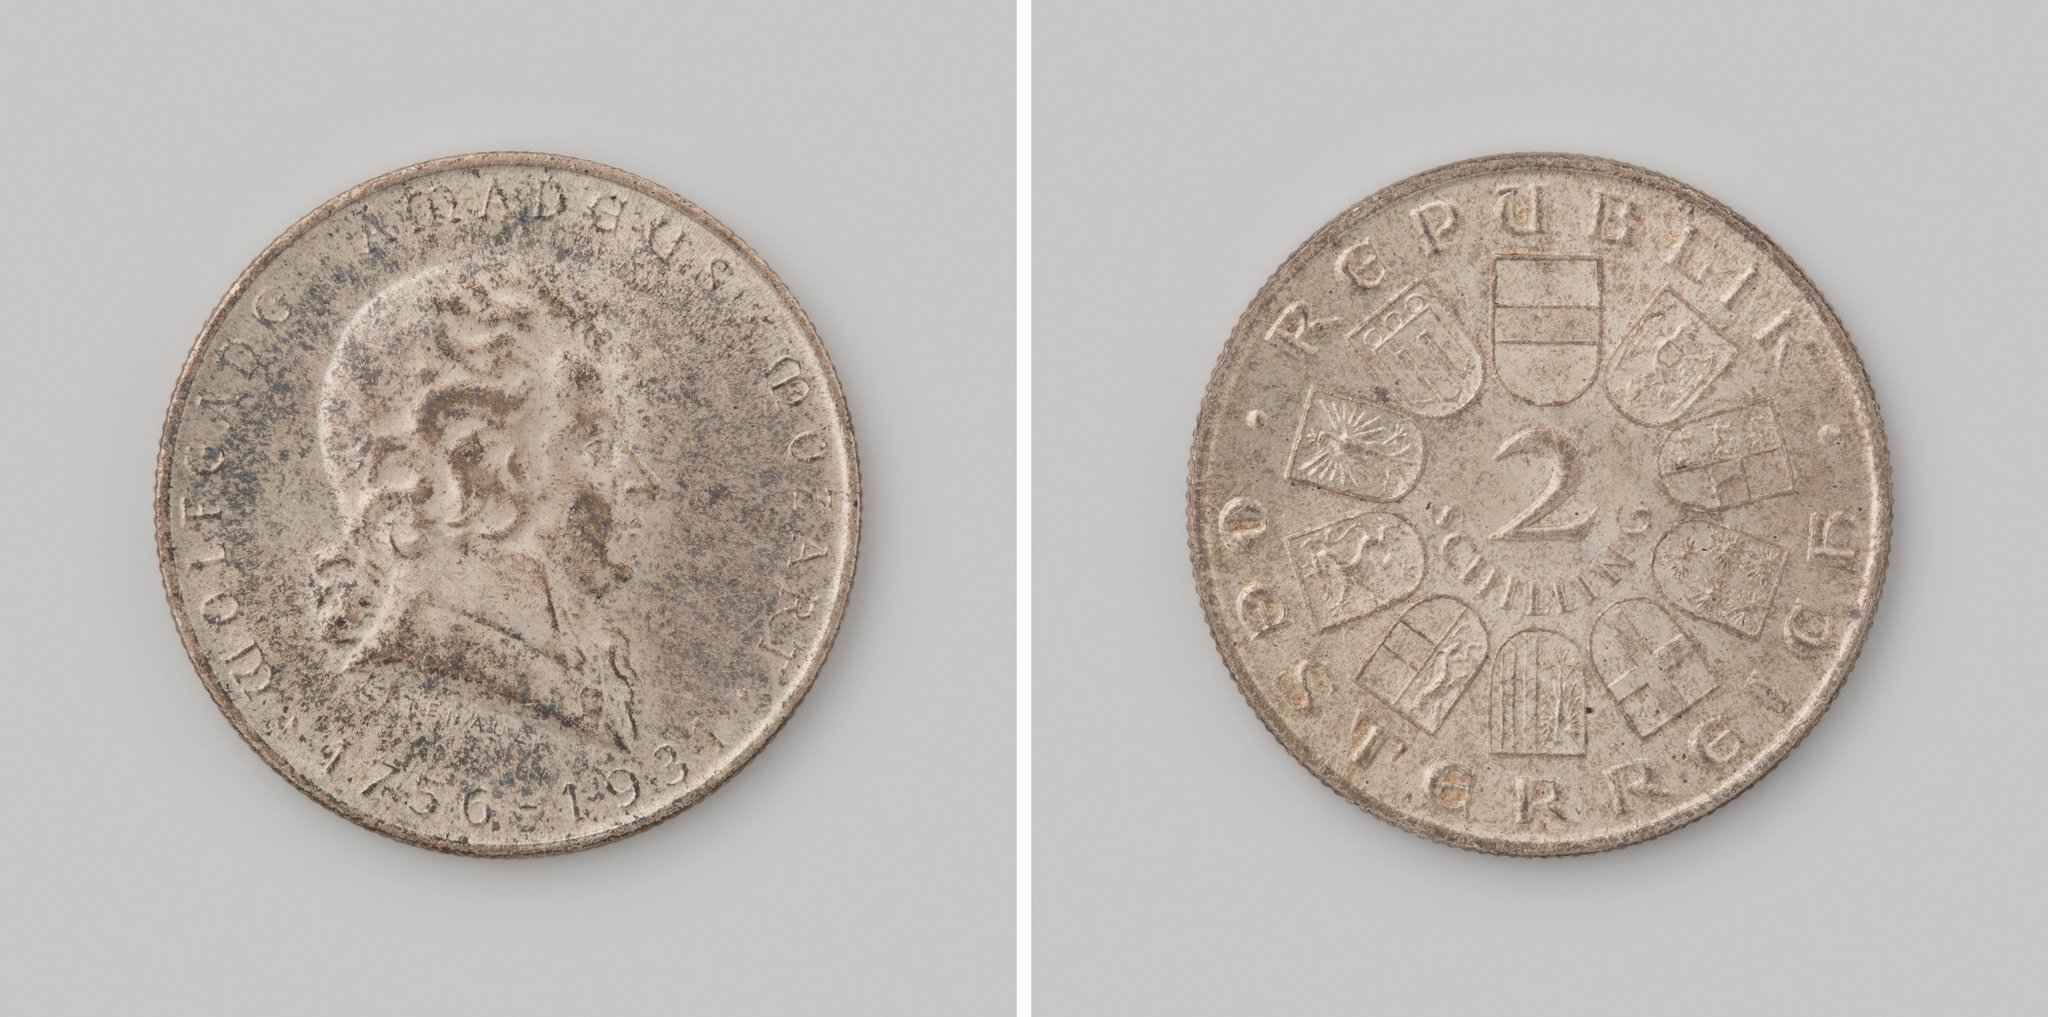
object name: coin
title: Republiek Oostenrijk, 2 schilling,1931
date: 1931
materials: silver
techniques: striking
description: Zilveren munt ter gelegenheid van de geboorte van Mozart175 jaar geleden. Voorzijde: portret van Mozart naar rechts, waaronder jaartal. Keerzijde: binnen een ring van tien wapenschilden waarde-aanduiding. Kartelrand.